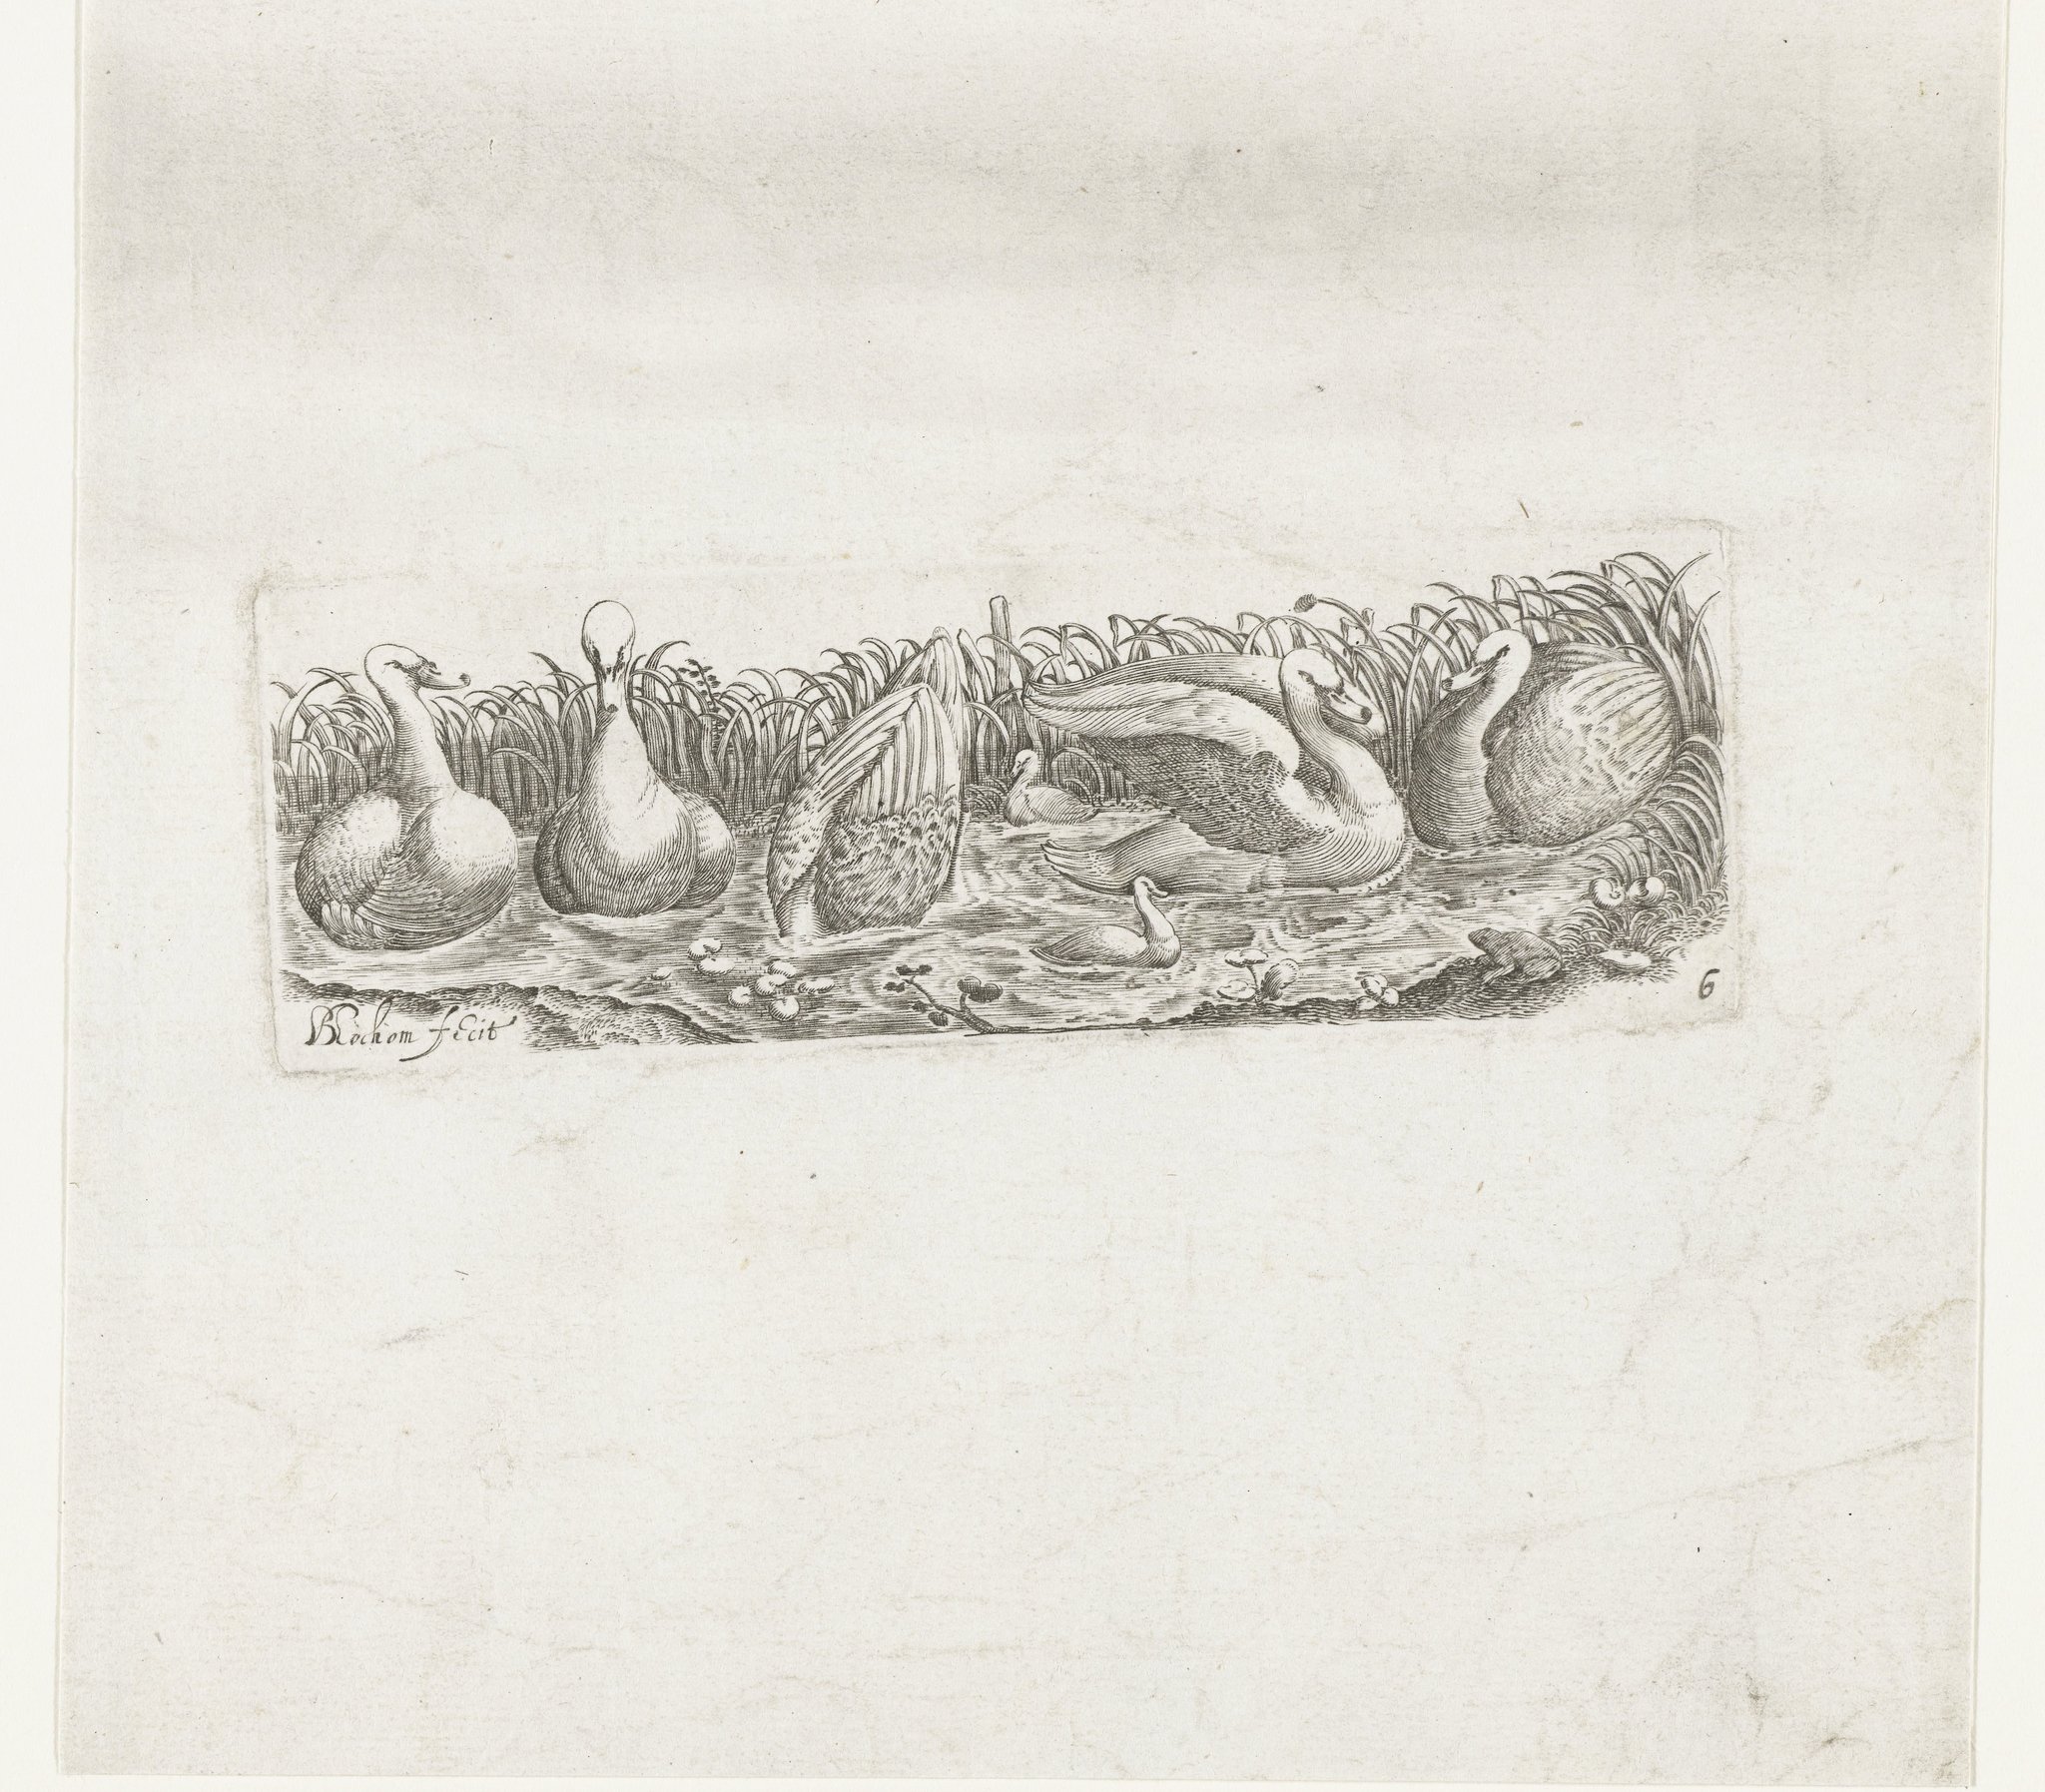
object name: print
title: Zeven zwemmende vogels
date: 1630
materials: paper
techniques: engraving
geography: amsterdam